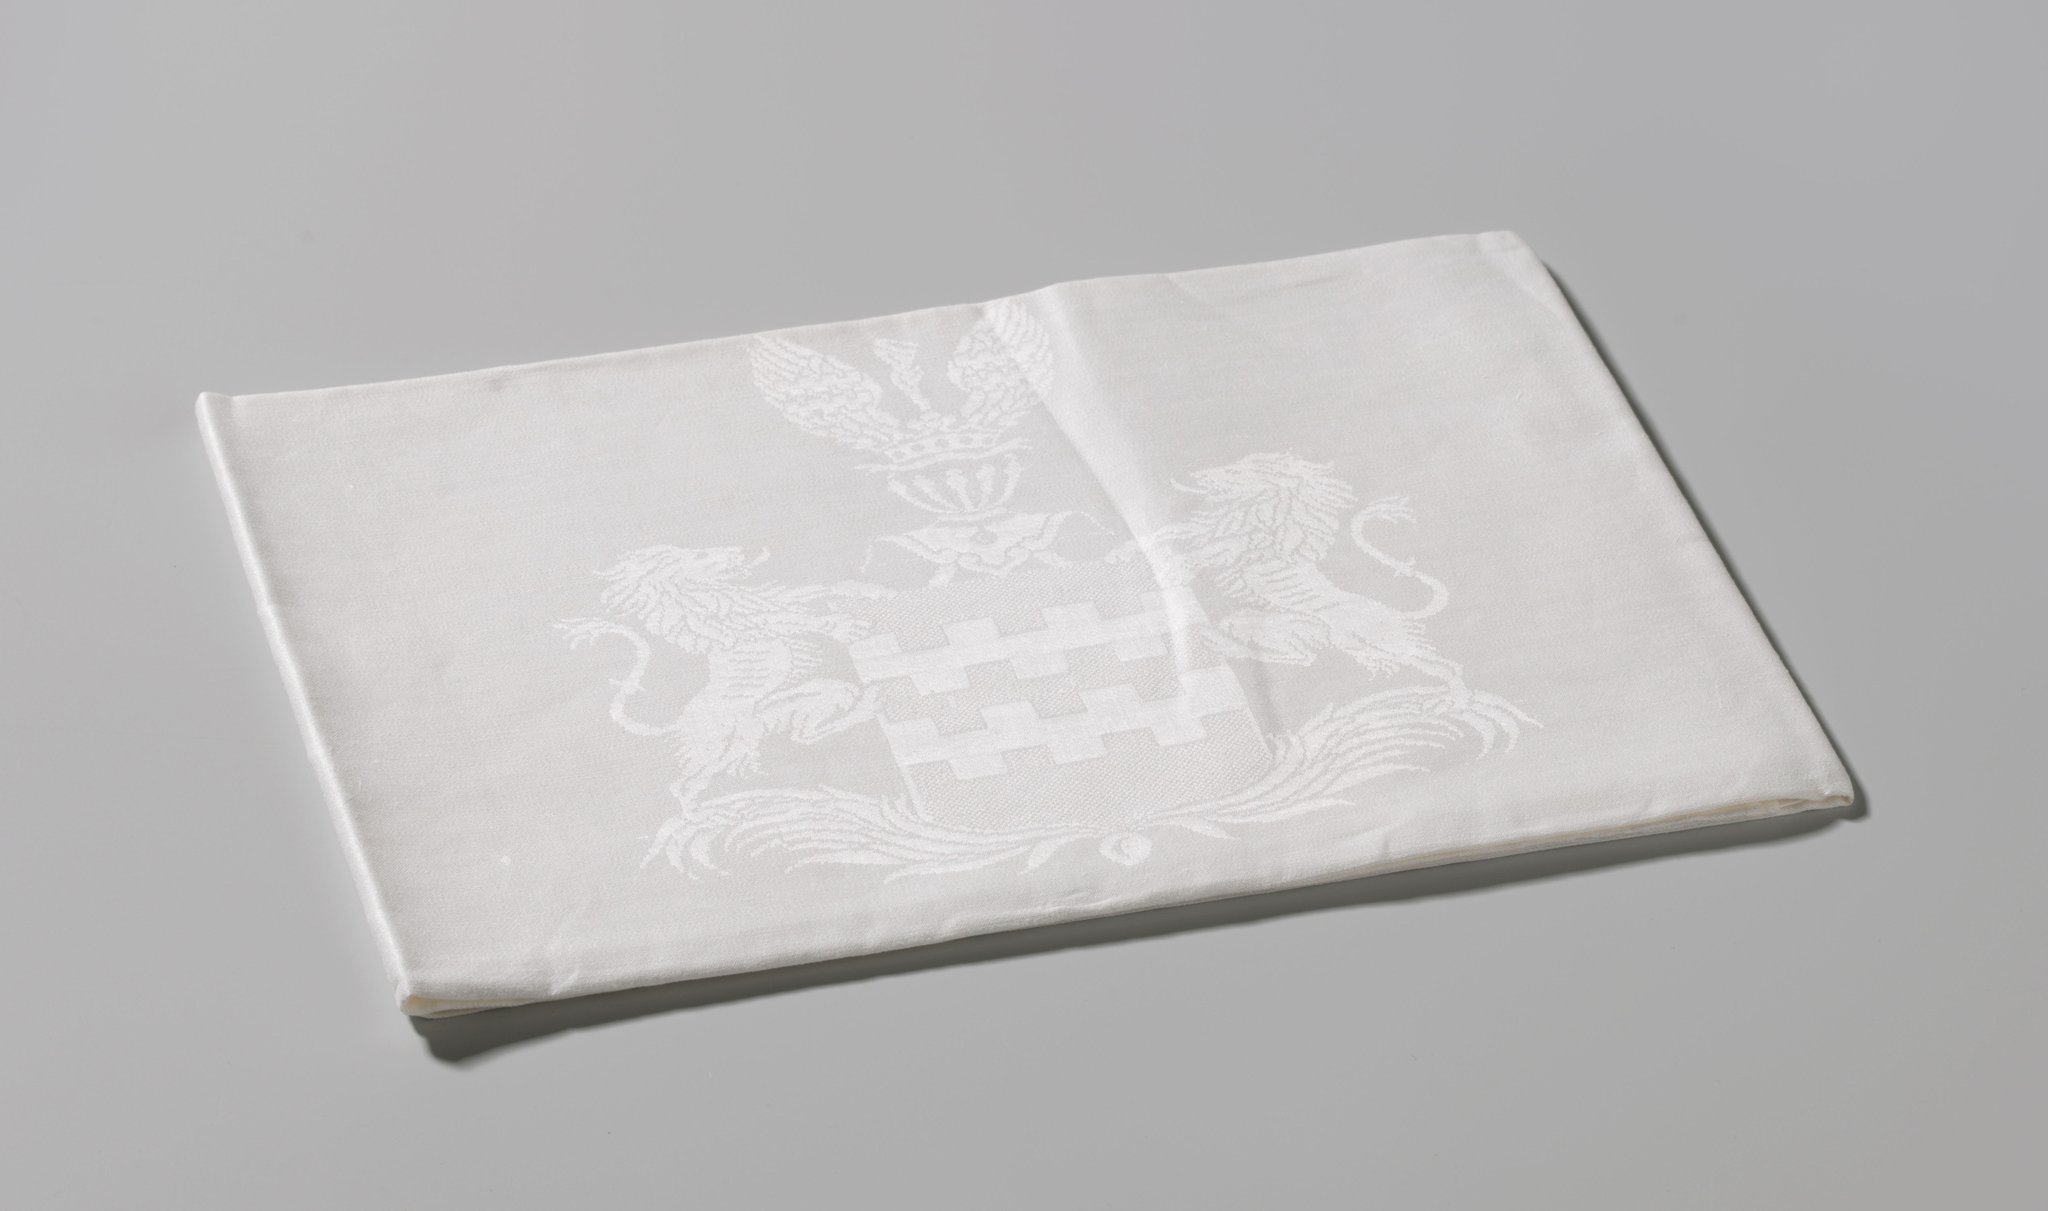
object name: napkin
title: Servet van wit linnendamast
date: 1874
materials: linen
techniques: damask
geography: north brabant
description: Wit linnen damasten servet met voluten en het wapen Van Boelens van der Haer.